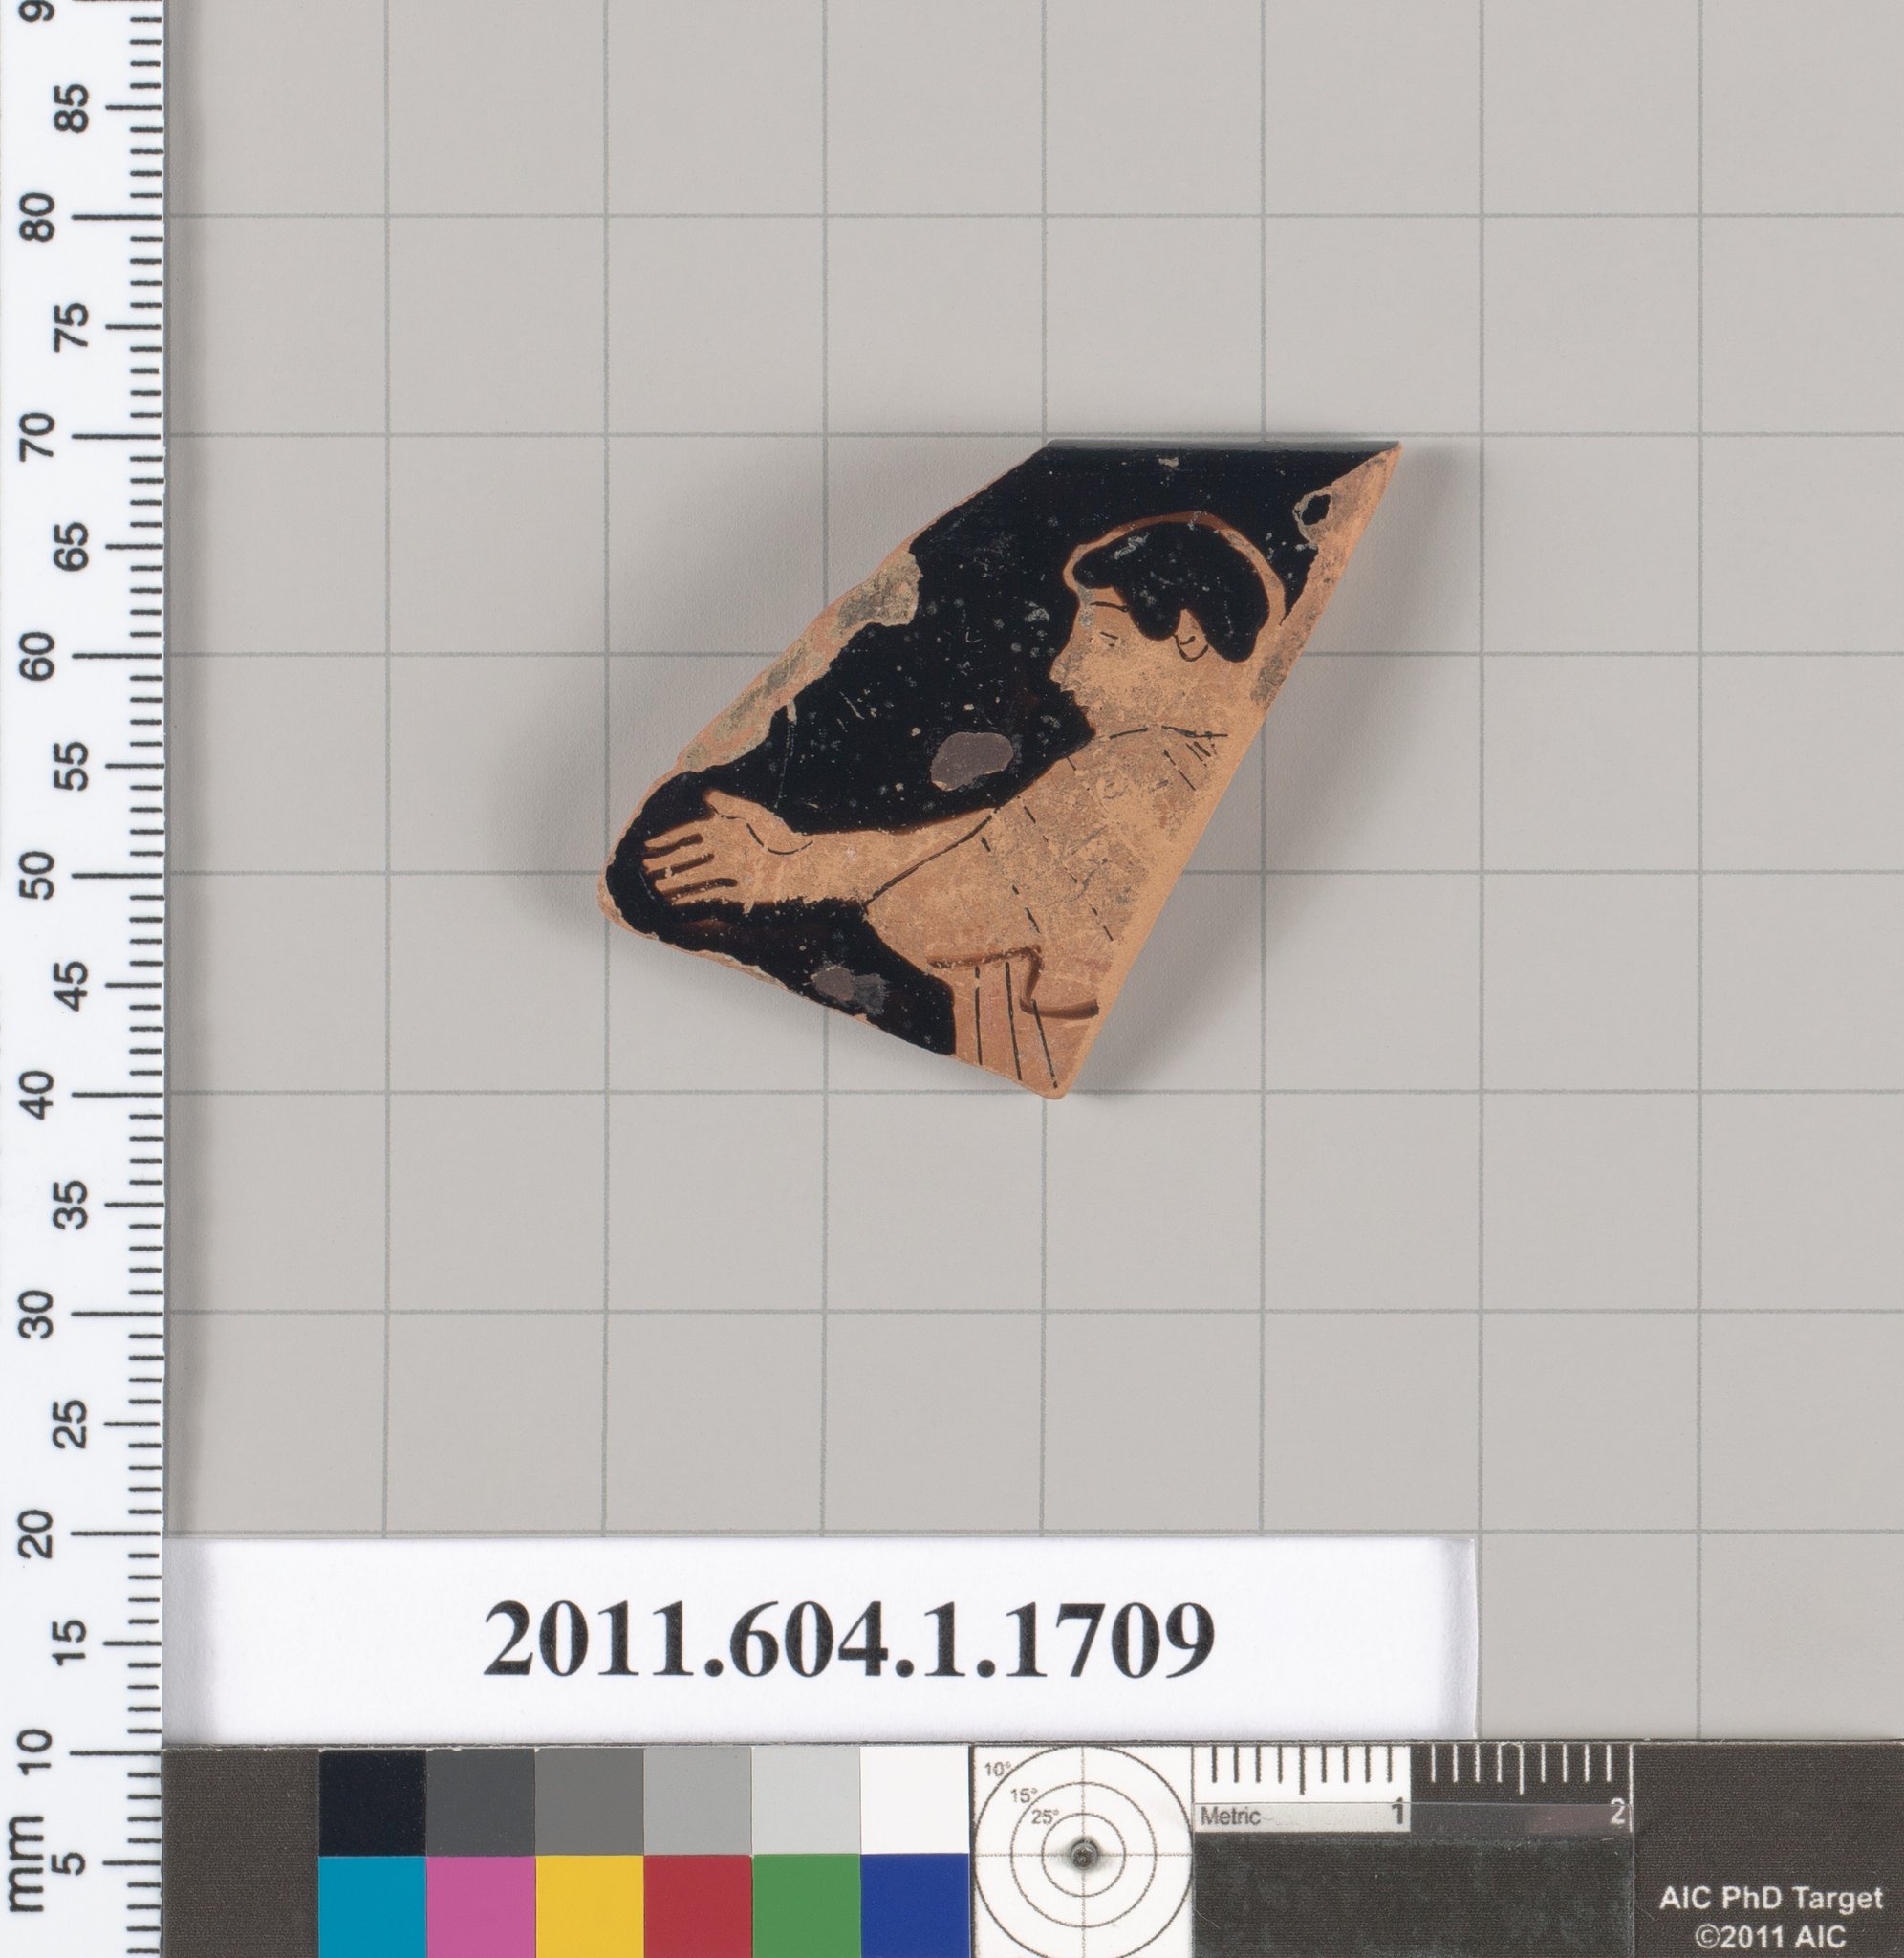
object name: kylix fragment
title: Terracotta rim fragment of a kylix (drinking cup)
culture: greek, attic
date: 475-451 BCE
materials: terracotta